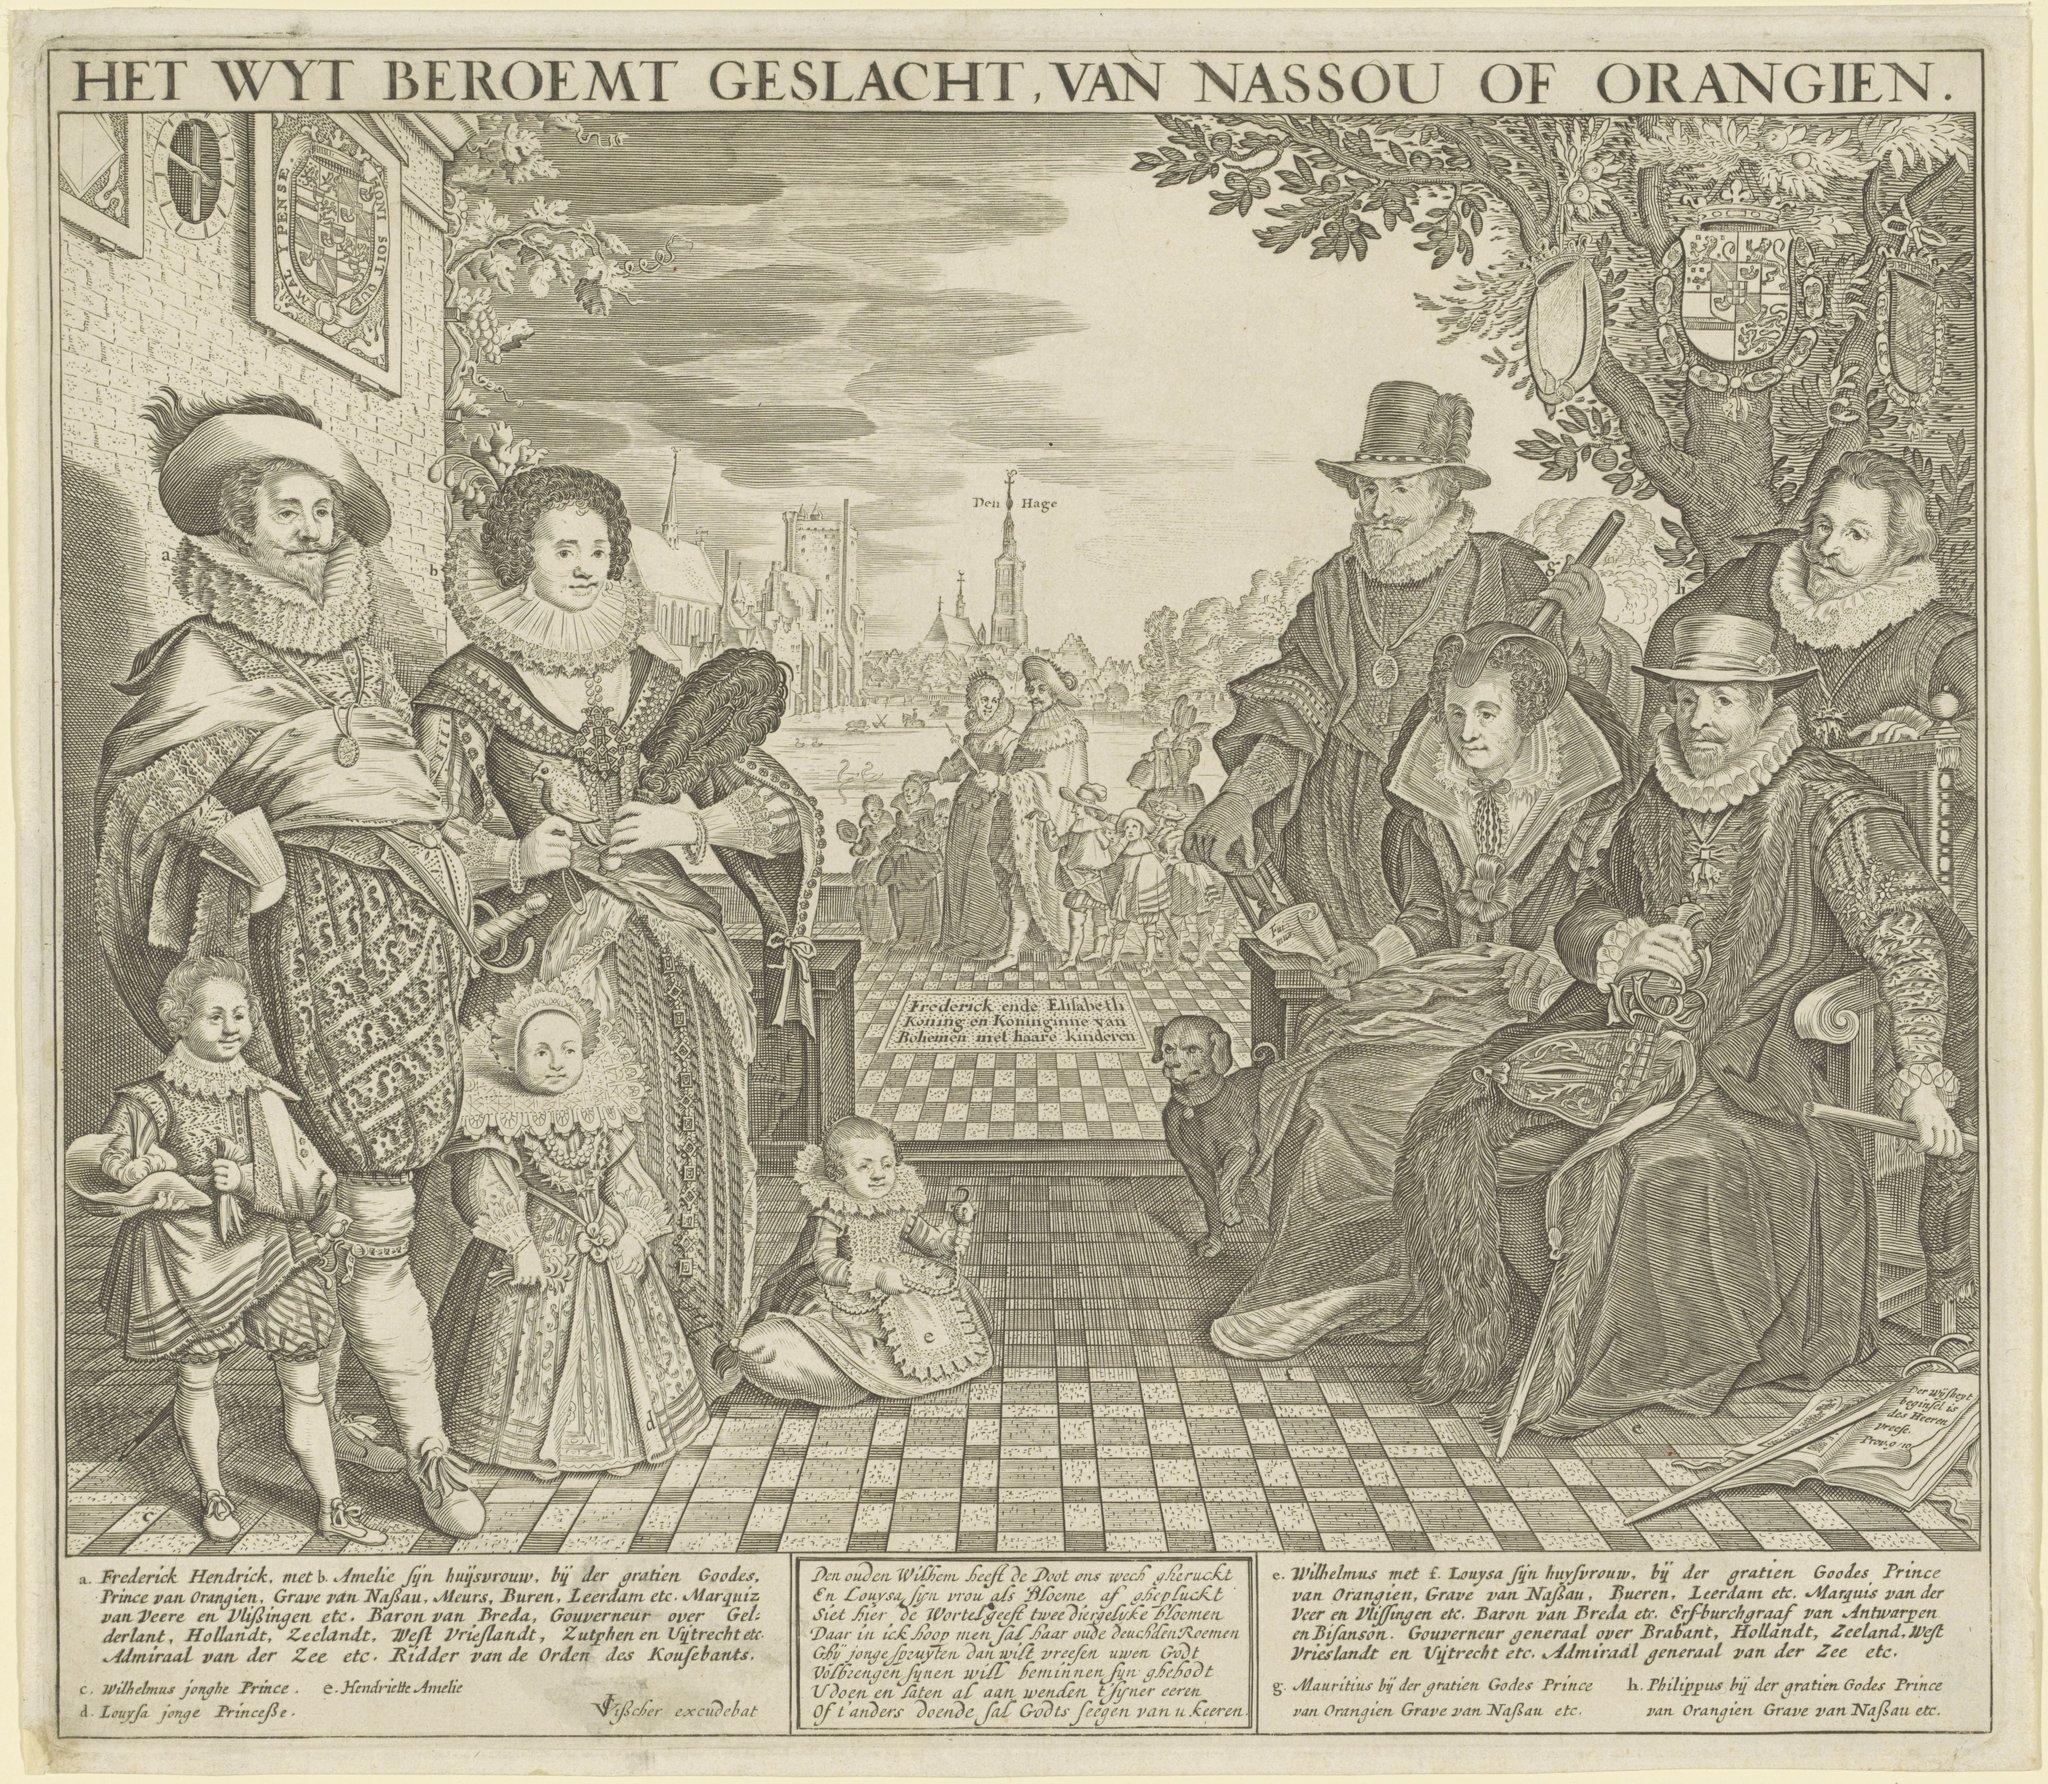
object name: print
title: Familieportret van Willem I, prins van Oranje, Louise de Coligny, Filips Willem, Maurits en Frederik Hendrik, prinsen van Oranje, Amalia van Solms, en hun kinderen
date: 1628-1652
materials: paper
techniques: engraving, etching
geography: amsterdam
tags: louise de coligny, frederick henry (prince of orange), william ii (prince of orange), delft, william i (prince of orange), the hague, maurice (prince of orange), amalia of solms-braunfels, louise henriëtte (prinses van oranje), amberg, frederik v (keurvorst van de palts, koning van bohemen), london, buren, bruges, filips willem (prins van oranje), knighthood order (garter) - insignia of a knighthood order, e.g.: badge, chain, knighthood order of the golden fleece - insignia of a knighthood order, e.g.: badge, chain (with name of order)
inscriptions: collector's mark: Lugt 963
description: Familieportret van Willem I, Louise, Filips Willem, Maurits, Frederik Hendrik, Amalia en hun kinderen Willem II, Louise Henriëtte en Henriëtte Amalia. Daar omheen een aantal allegorische objecten. Op de achtergrond Frederik V, Elisabeth Stuart, hun kinderen en de stad Den Haag. In de bovenmarge een regel Nederlandse tekst. In de ondermarge hun namen, hun titels en acht regels Nederlandse tekst.